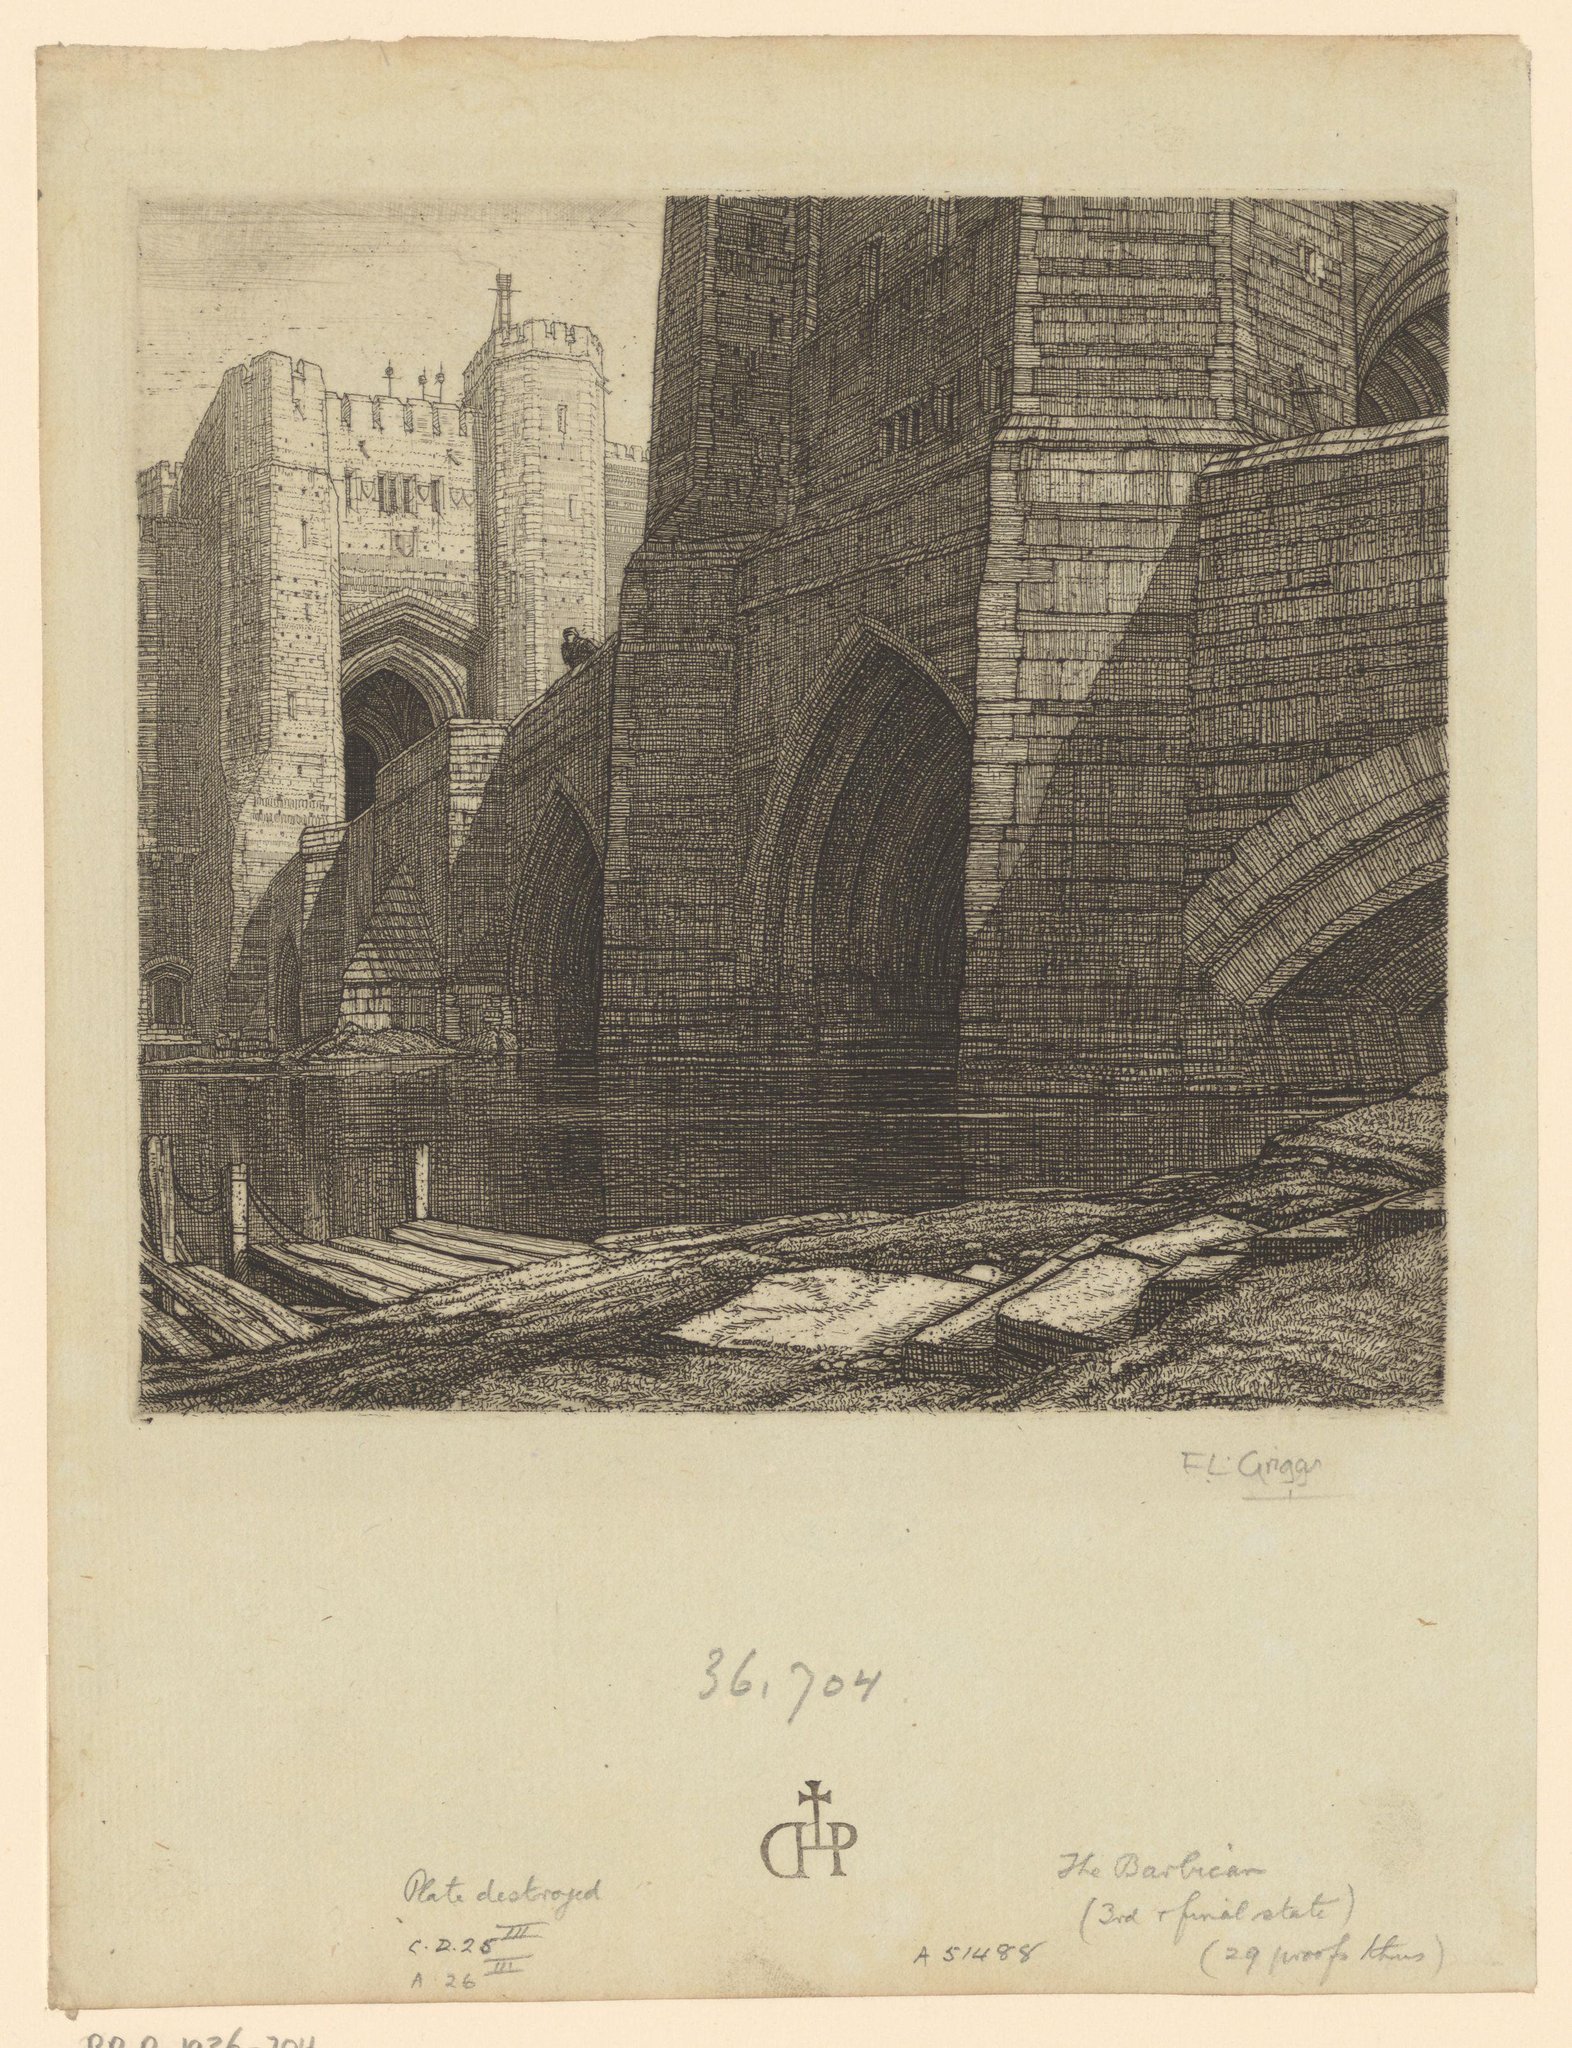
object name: print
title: Versterkte, stenen brug en stadspoort van een ommuurde stad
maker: frederick landseer maur griggs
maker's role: print maker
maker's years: 1876-1938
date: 1915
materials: paper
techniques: etching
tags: gate ~ fortified city, moat ~ fortified city, bridge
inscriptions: signature: ‘F.L. Griggs’, collector's mark: Lugt 760a, collector's mark: Lugt 2228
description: Dodgson en Alexander noemen drie staten van 'The Barbican'. Deze prent komt echter van de versneden, opgewerkte plaat van Griggs' prent 'The Cresset' (1915), ook met twee staten. Zodoende komt het totaal van deze plaat op vijf staten uit.